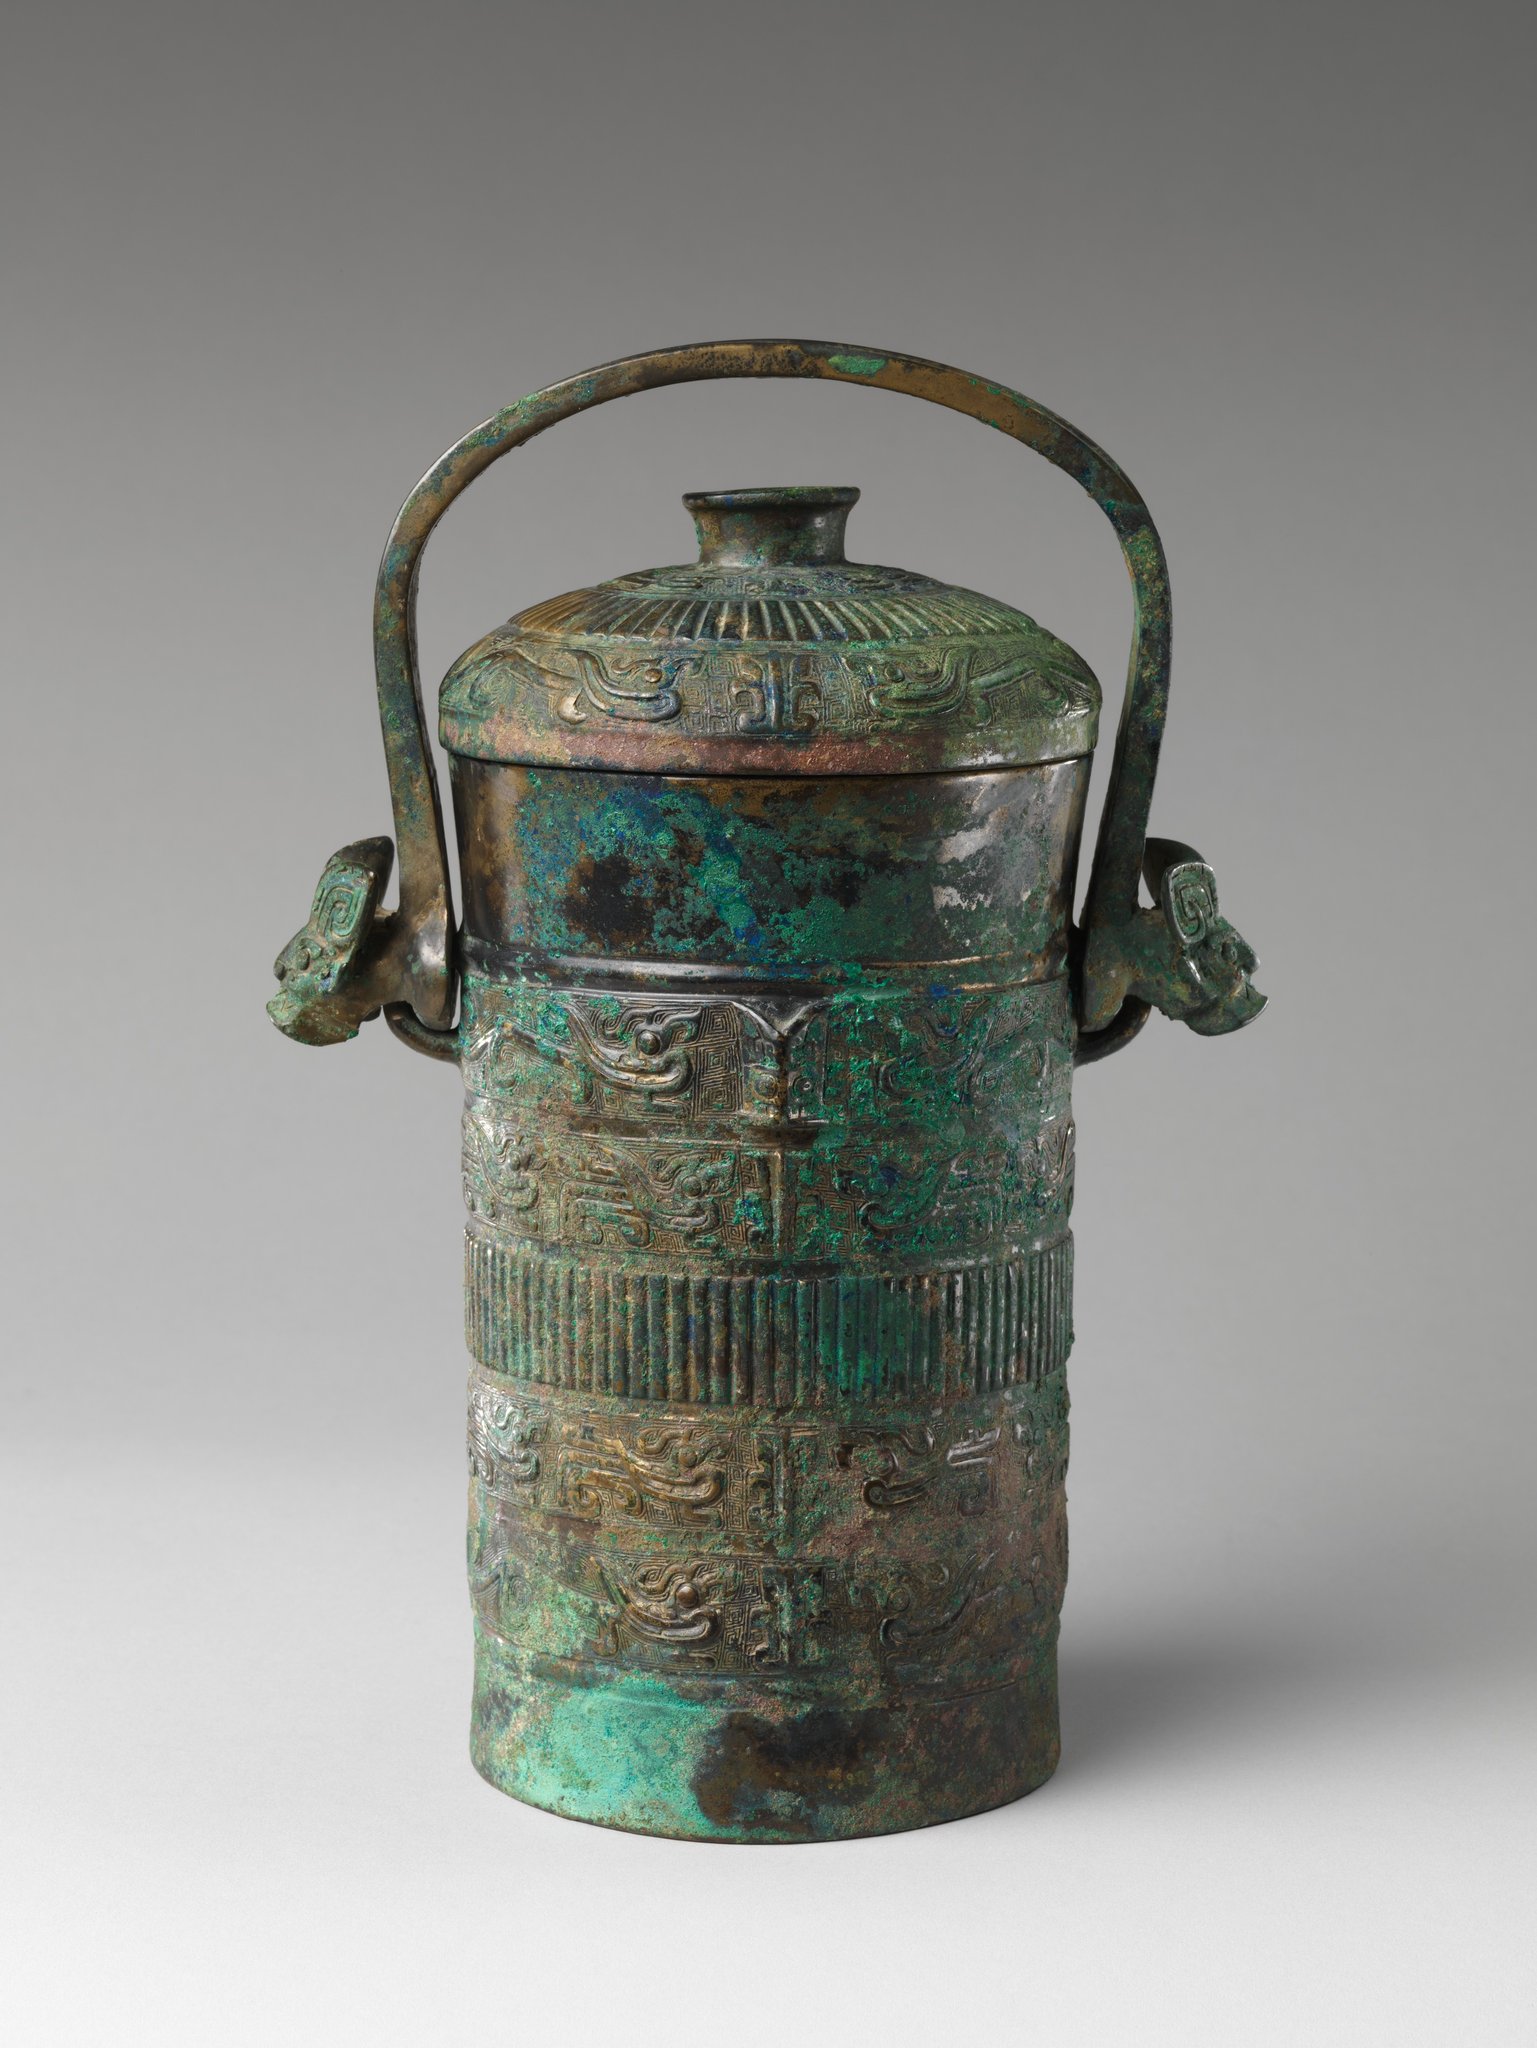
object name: wine container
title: Wine container with handle (you)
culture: chinese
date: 1100-901 BCE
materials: bronze